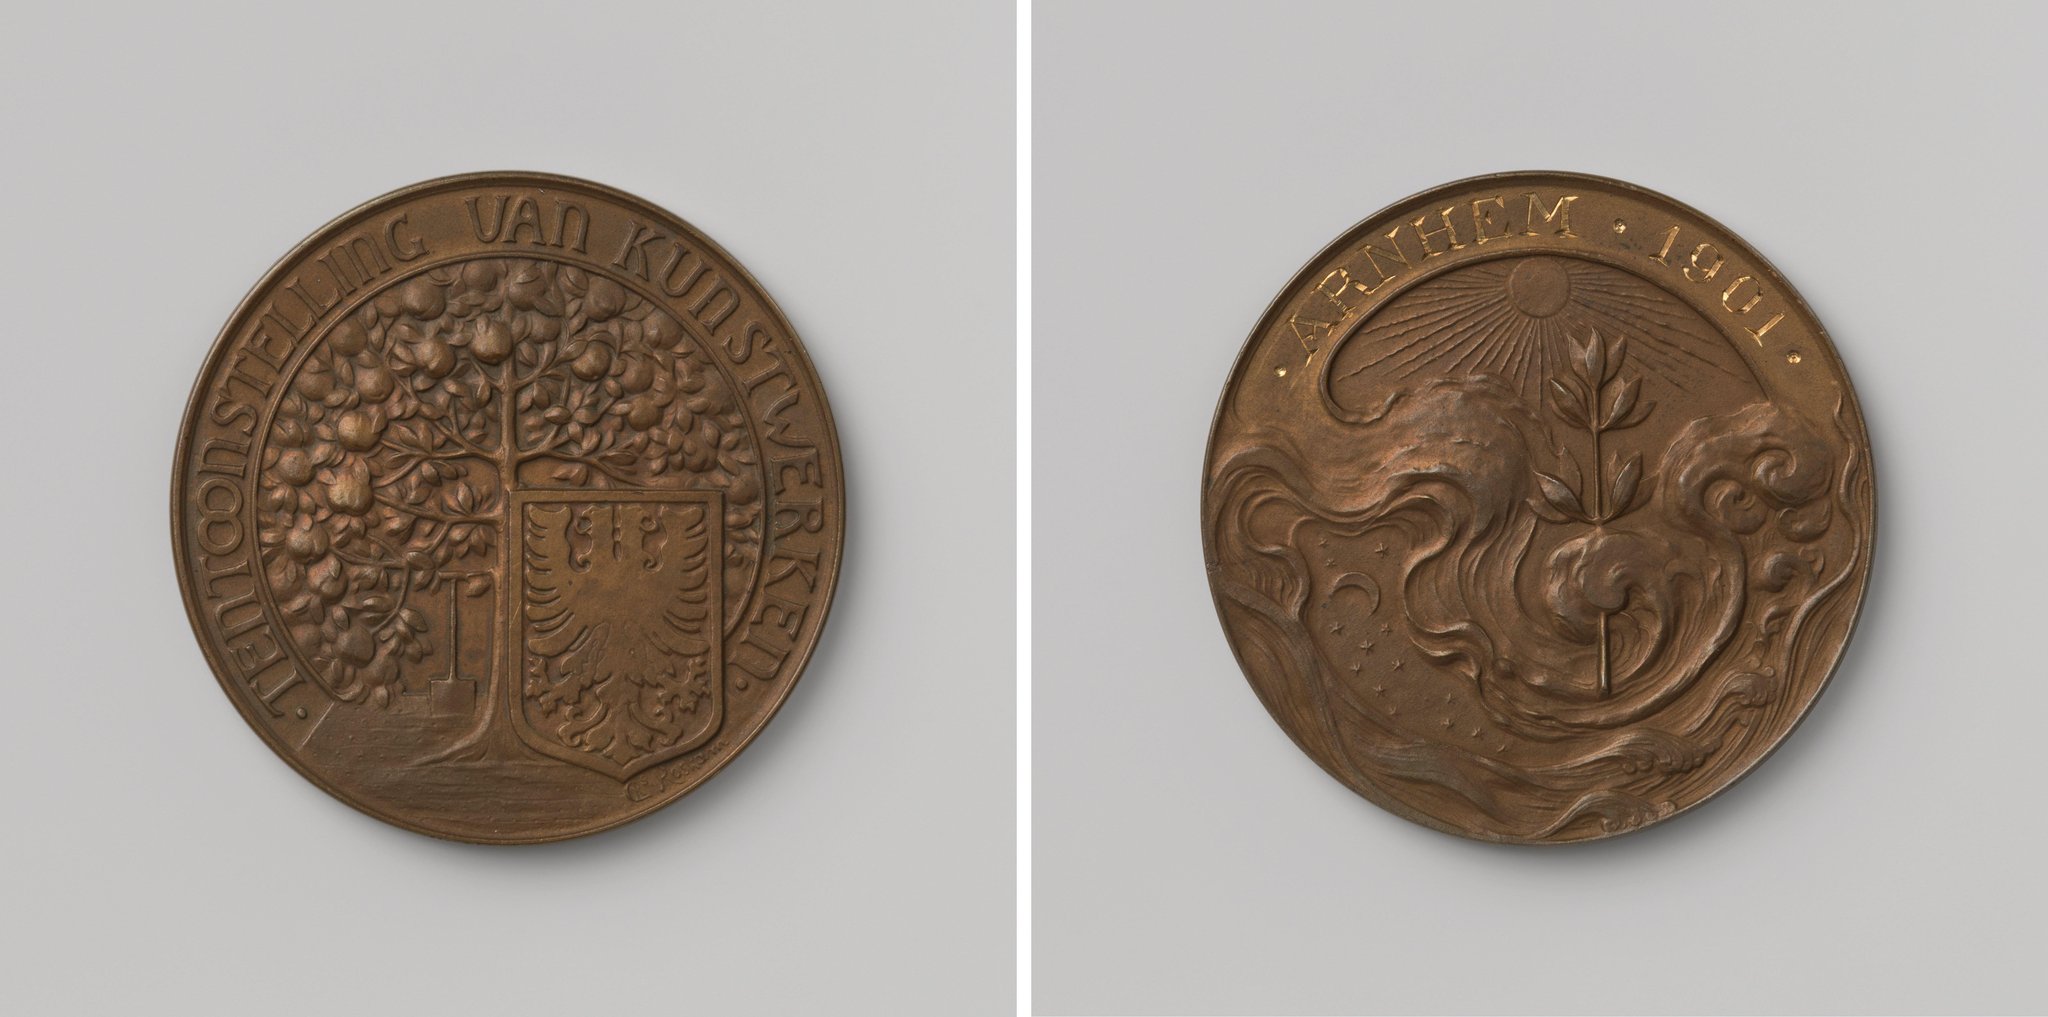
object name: medal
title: vierjaarlijkse tentoonstelling van kunstwerken te Arnhem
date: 1901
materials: bronze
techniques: striking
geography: netherlands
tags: arnhem